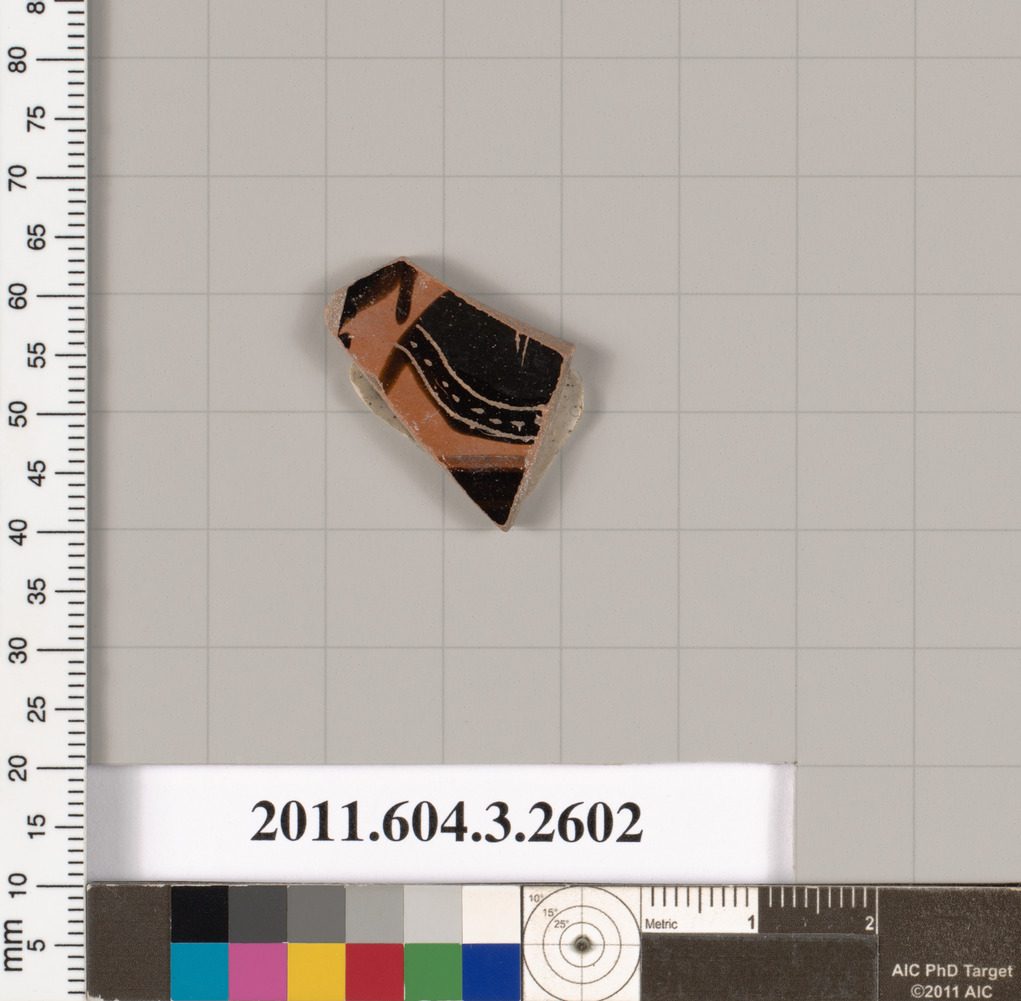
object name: kylix fragment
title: Terracotta fragment of a kylix: Band cup (drinking cup)?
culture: greek, attic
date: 550-526 BCE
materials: terracotta